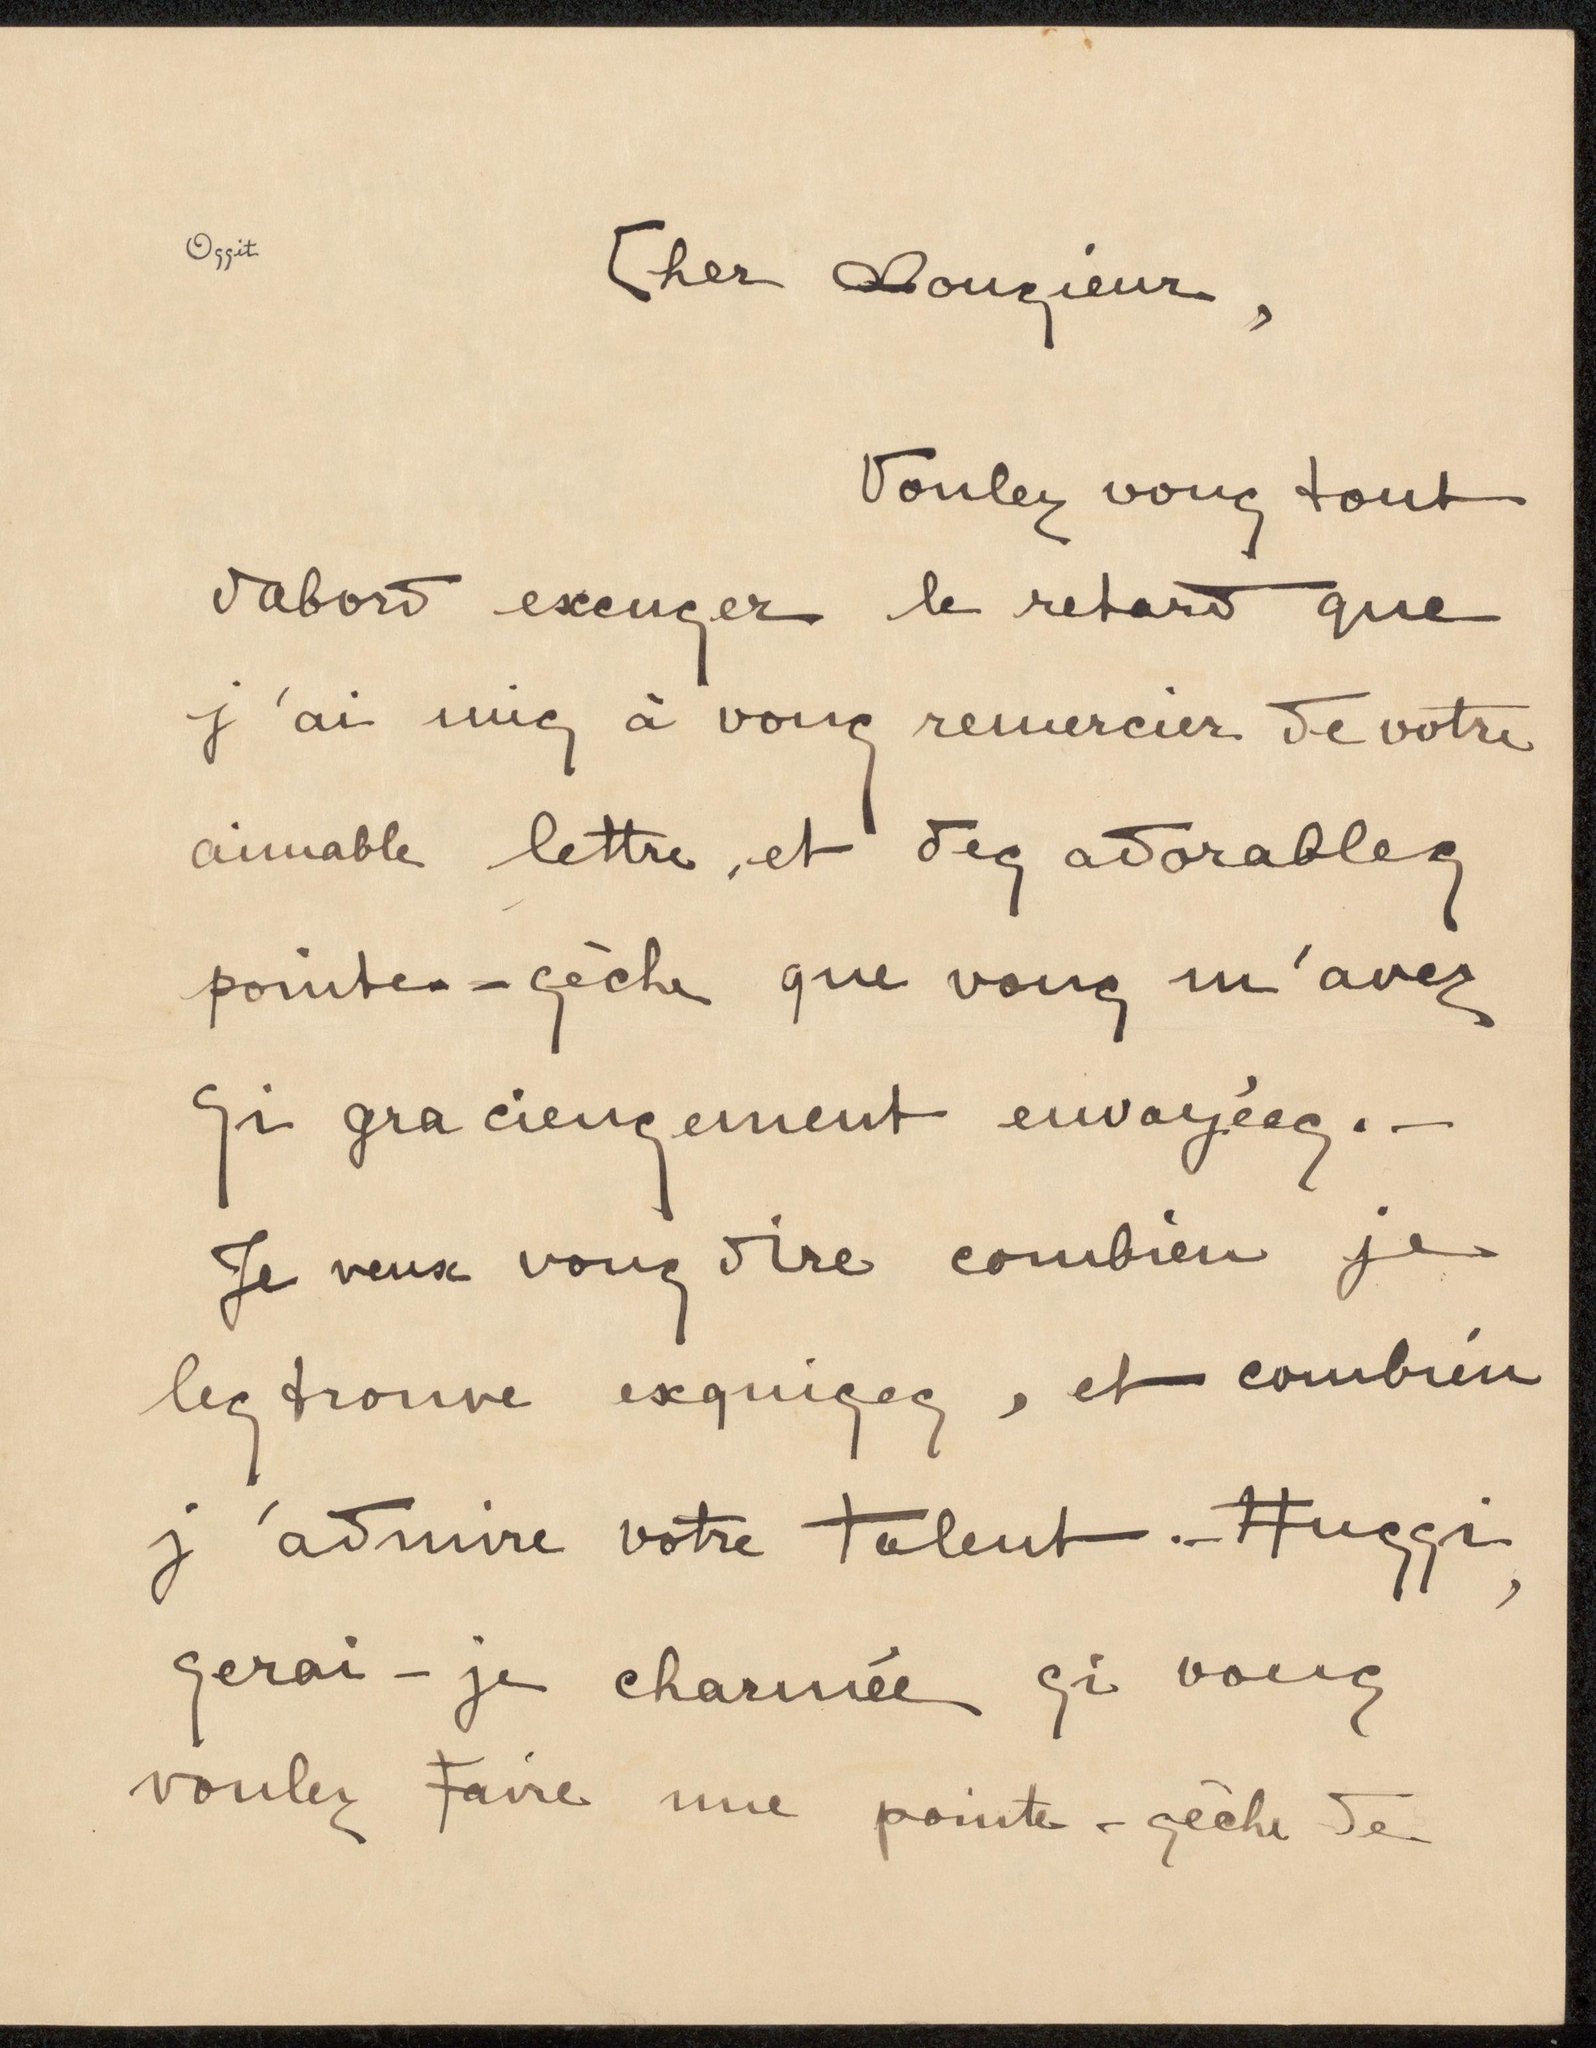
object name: letter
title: Brief aan Philip Zilcken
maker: baronne madeleine deslandes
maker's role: schrijver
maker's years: 1866-1929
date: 1895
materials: ink, paper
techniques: pen, writing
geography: paris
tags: painter, draughtsman, philip zilcken, photography, cinematography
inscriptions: collector's mark: ‘RPK’